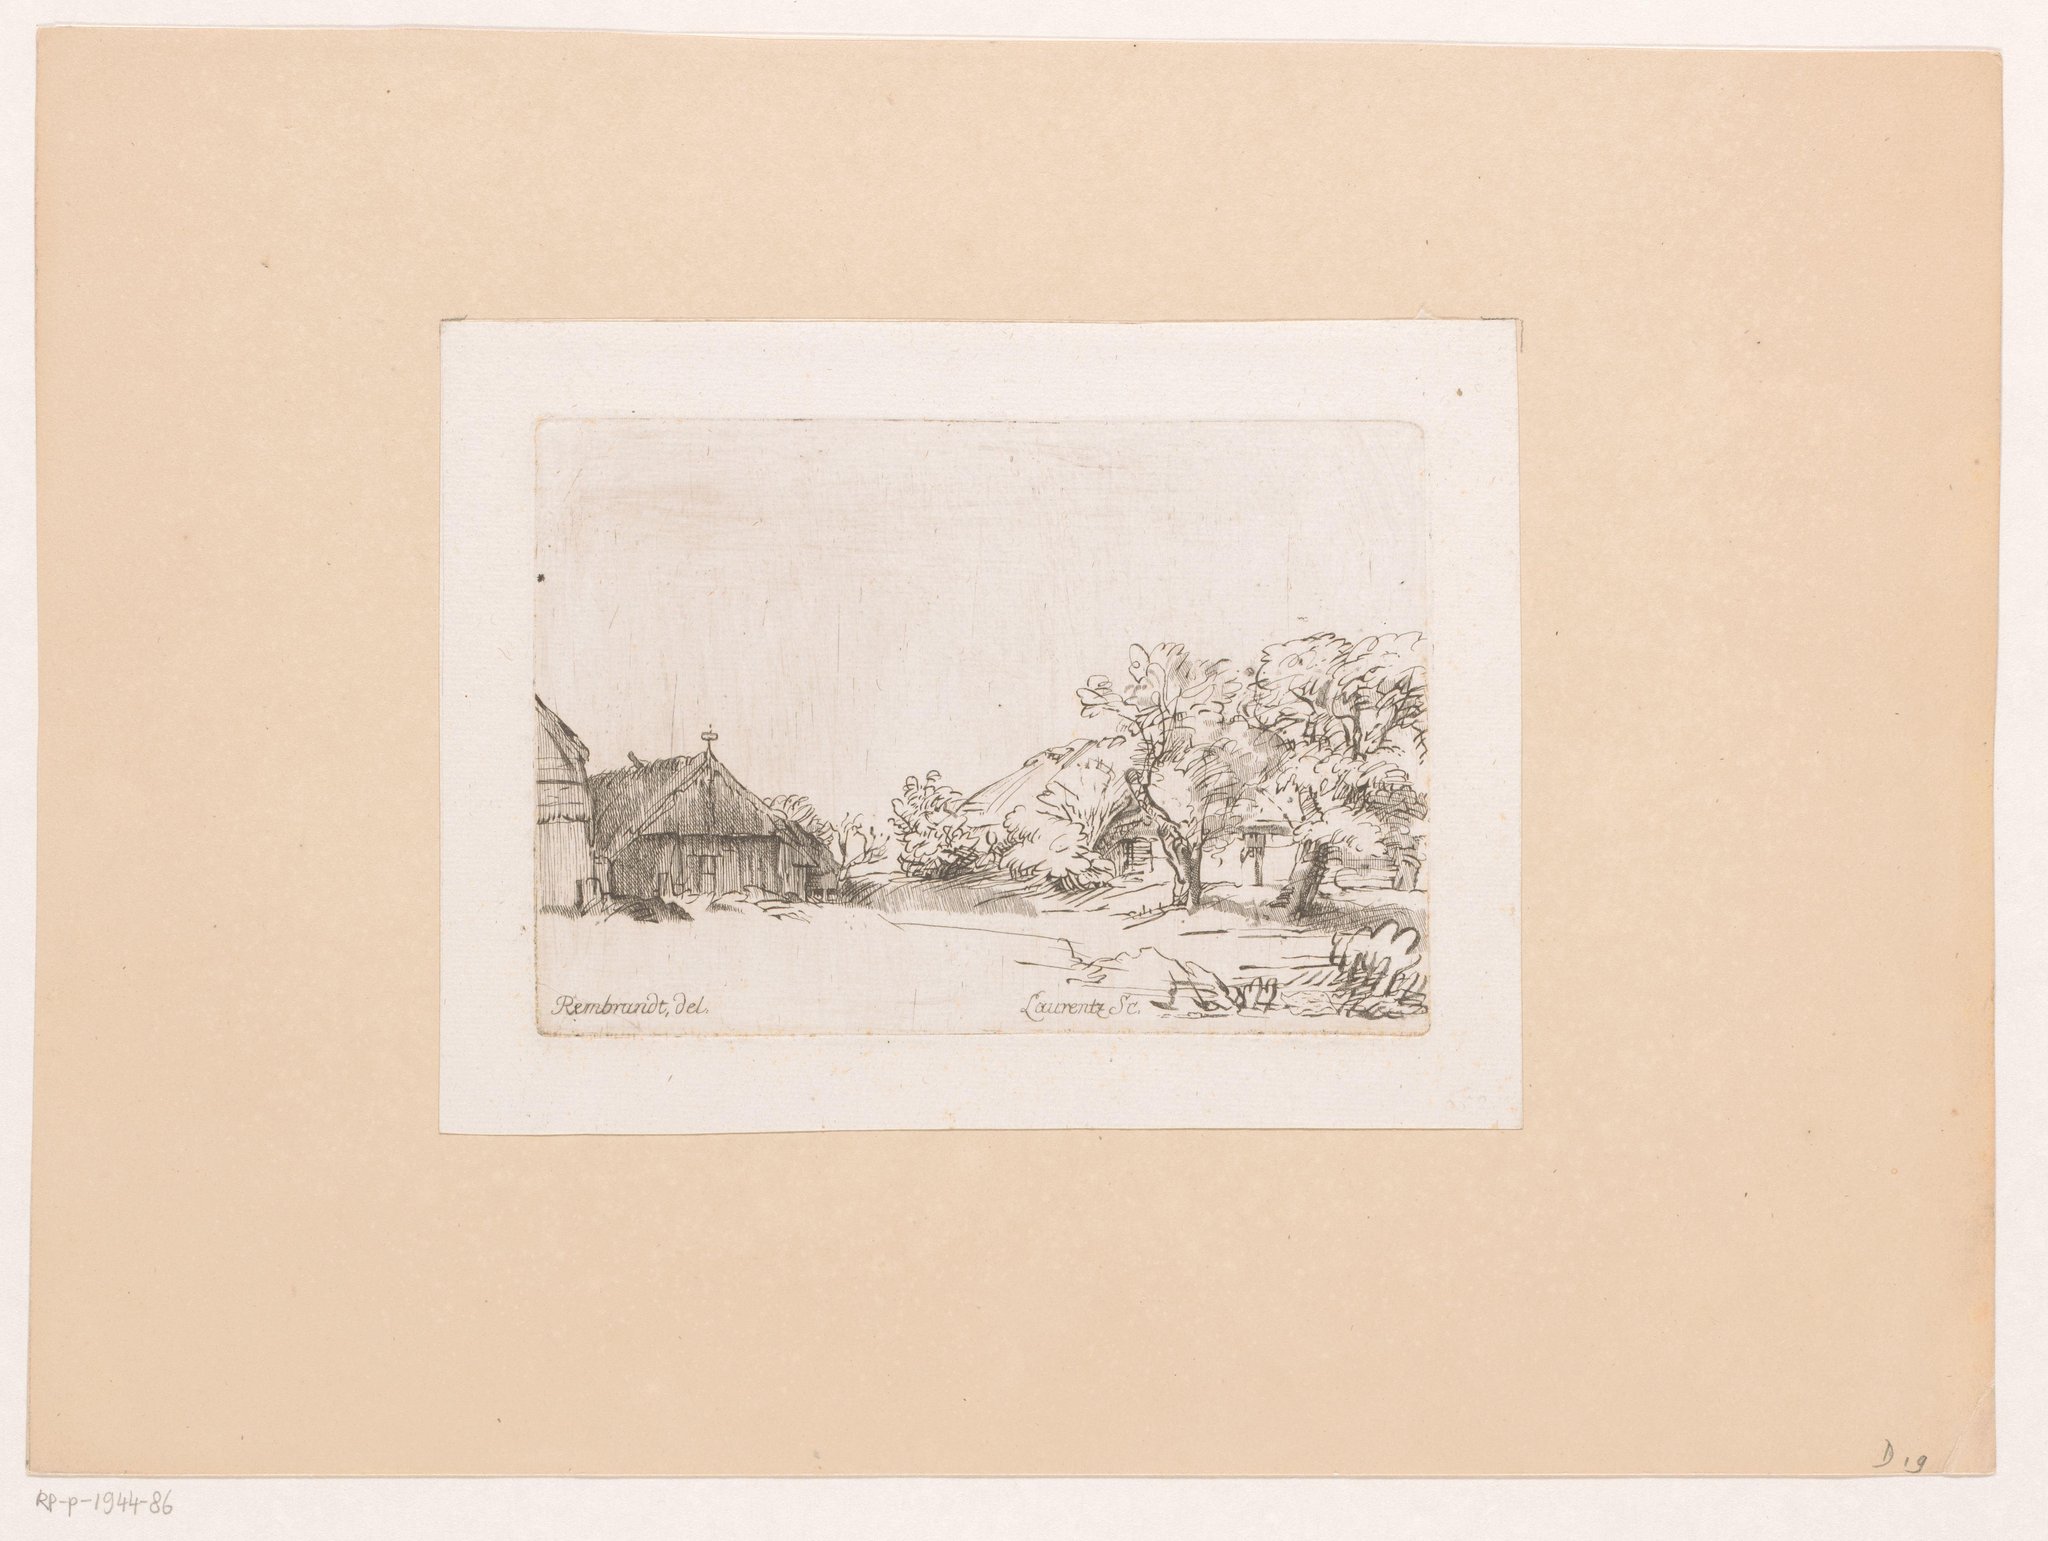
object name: print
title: Gezicht op boerderijen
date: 1739-1810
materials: paper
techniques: etching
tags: farm or solitary house in landscape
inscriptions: collector's mark: Lugt 2228